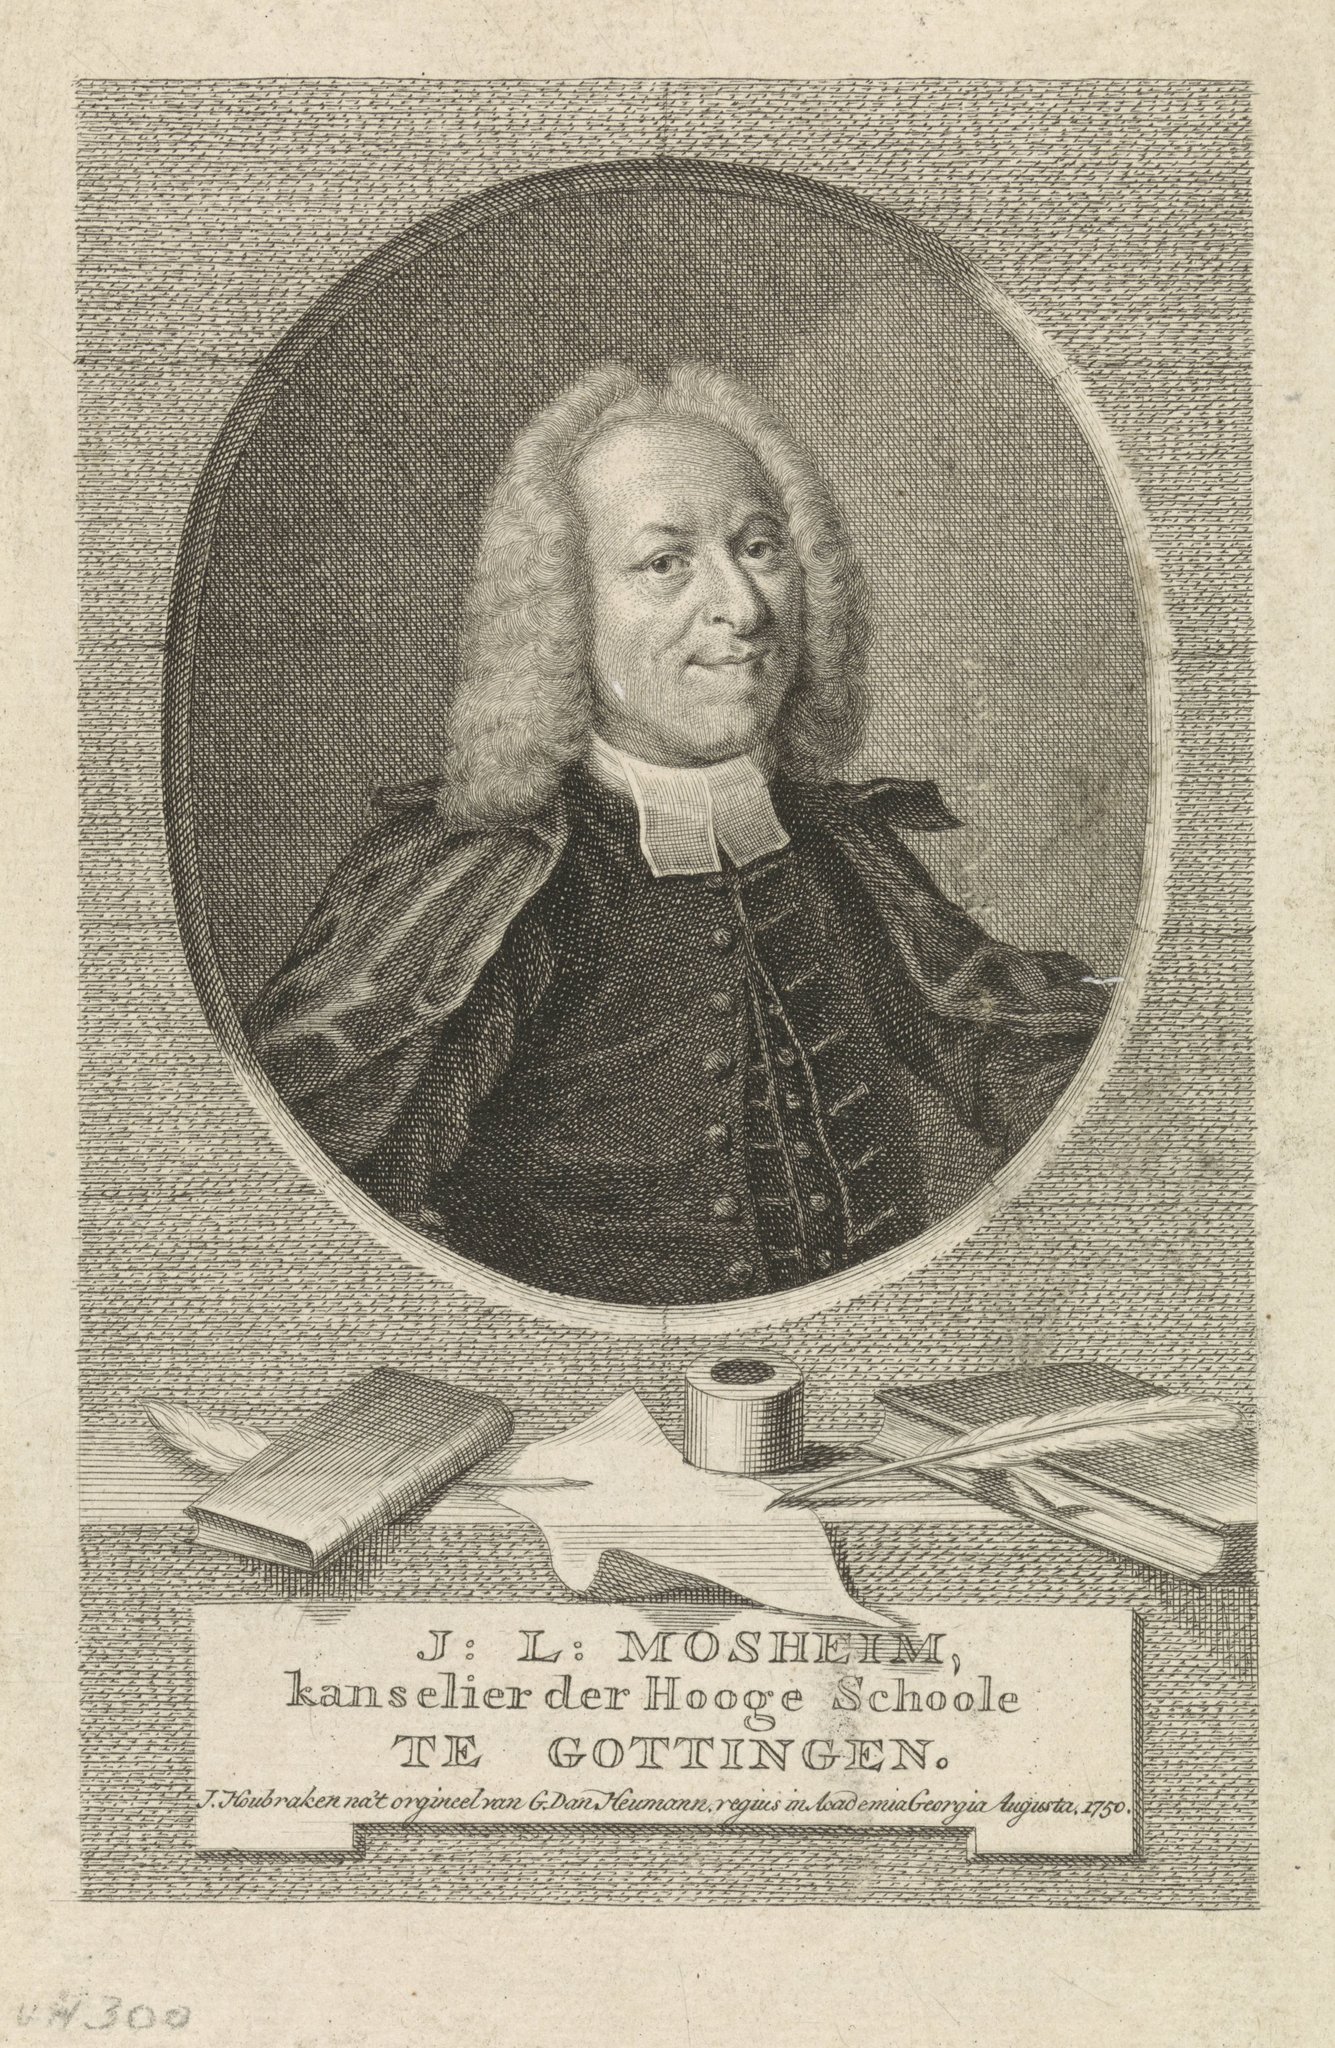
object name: print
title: J: L: Mosheim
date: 1750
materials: paper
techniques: engraving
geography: amsterdam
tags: quill, ink-well, paper (writing material)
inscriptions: collector's mark: Lugt 2228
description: Buste naar rechts van Johann Lorenz von Mosheim in een architectonisch ovaal. Onder het ovaal een richel waarop boeken, een vel papier, schrijfveren en een inktpot. Daaronder zijn naam en gegevens in drie regels in het Nederlands.